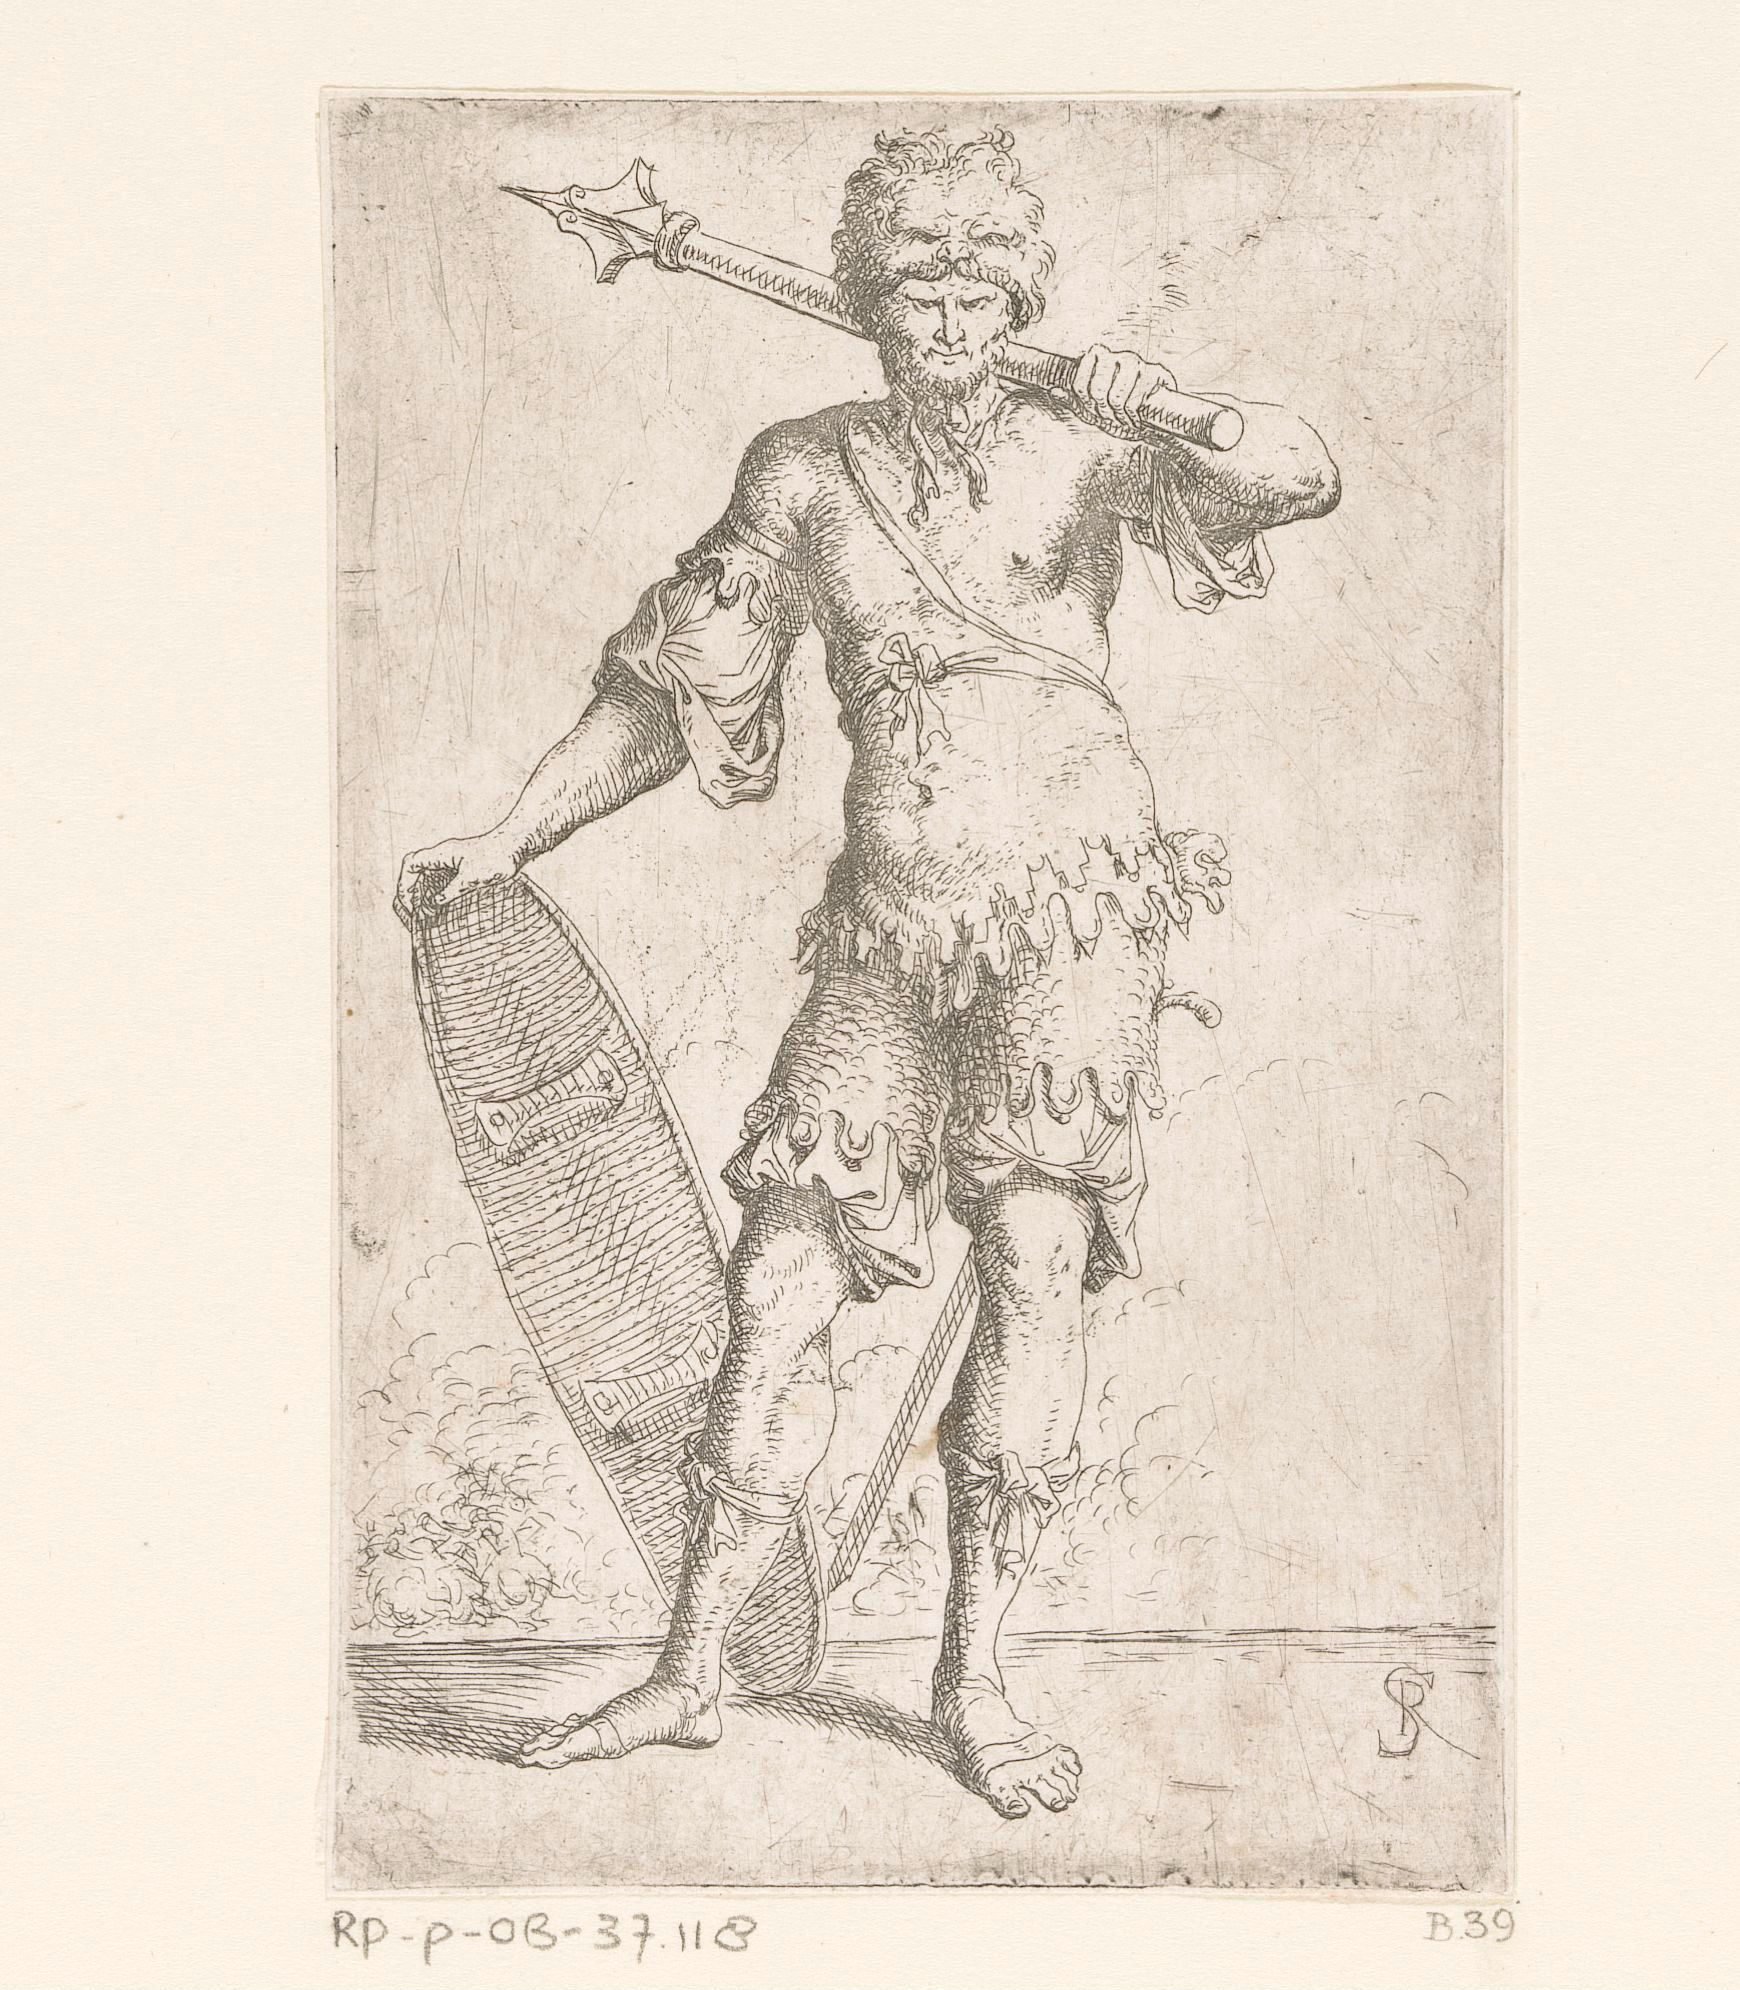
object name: print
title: Kleine figuren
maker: salvator rosa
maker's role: draughtsman, painter, print maker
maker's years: 1615-1673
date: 1656-1657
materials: paper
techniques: drypoint, etching, intaglio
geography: italy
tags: protective weapons: shield, the soldier; the soldier's life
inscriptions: collector's mark: Lugt 240, number: ‘29’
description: Prent spiegelbeeldig naar een tekening die zich eens bevond in de collectie van Ladislao Odescalchi te Rome (mogelijk bevindt de tekening zich niet meer in deze collectie). Deze prent maakt deel uit van de serie 'Figurine', bestaande uit een titelprent en 80 prenten van klein formaat met voorstellingen van mannelijke en vrouwelijke figuren. Rosa produceerde de serie waarschijnlijk gedurende de jaren 1656 en 1657.